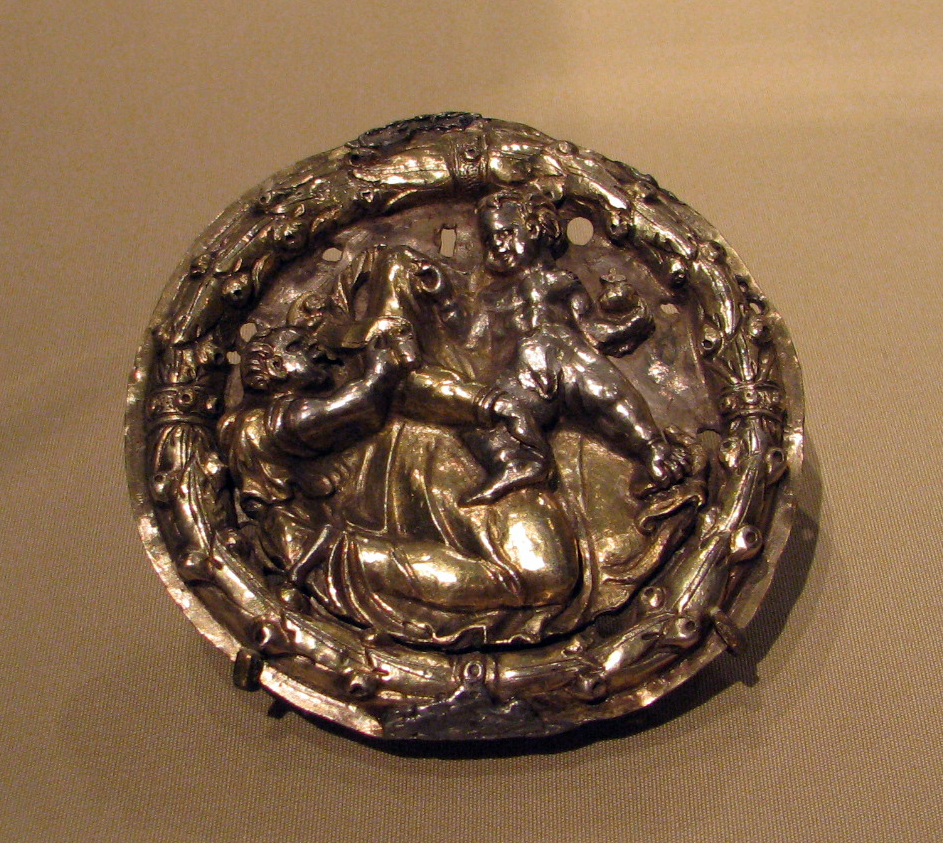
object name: medallion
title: Virgin and Child with Young Saint John the Baptist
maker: francisco beccerril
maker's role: artist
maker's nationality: spanish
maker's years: 1494-1572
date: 1501-1600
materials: silver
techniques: gilding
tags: madonna and child,saint john the baptist